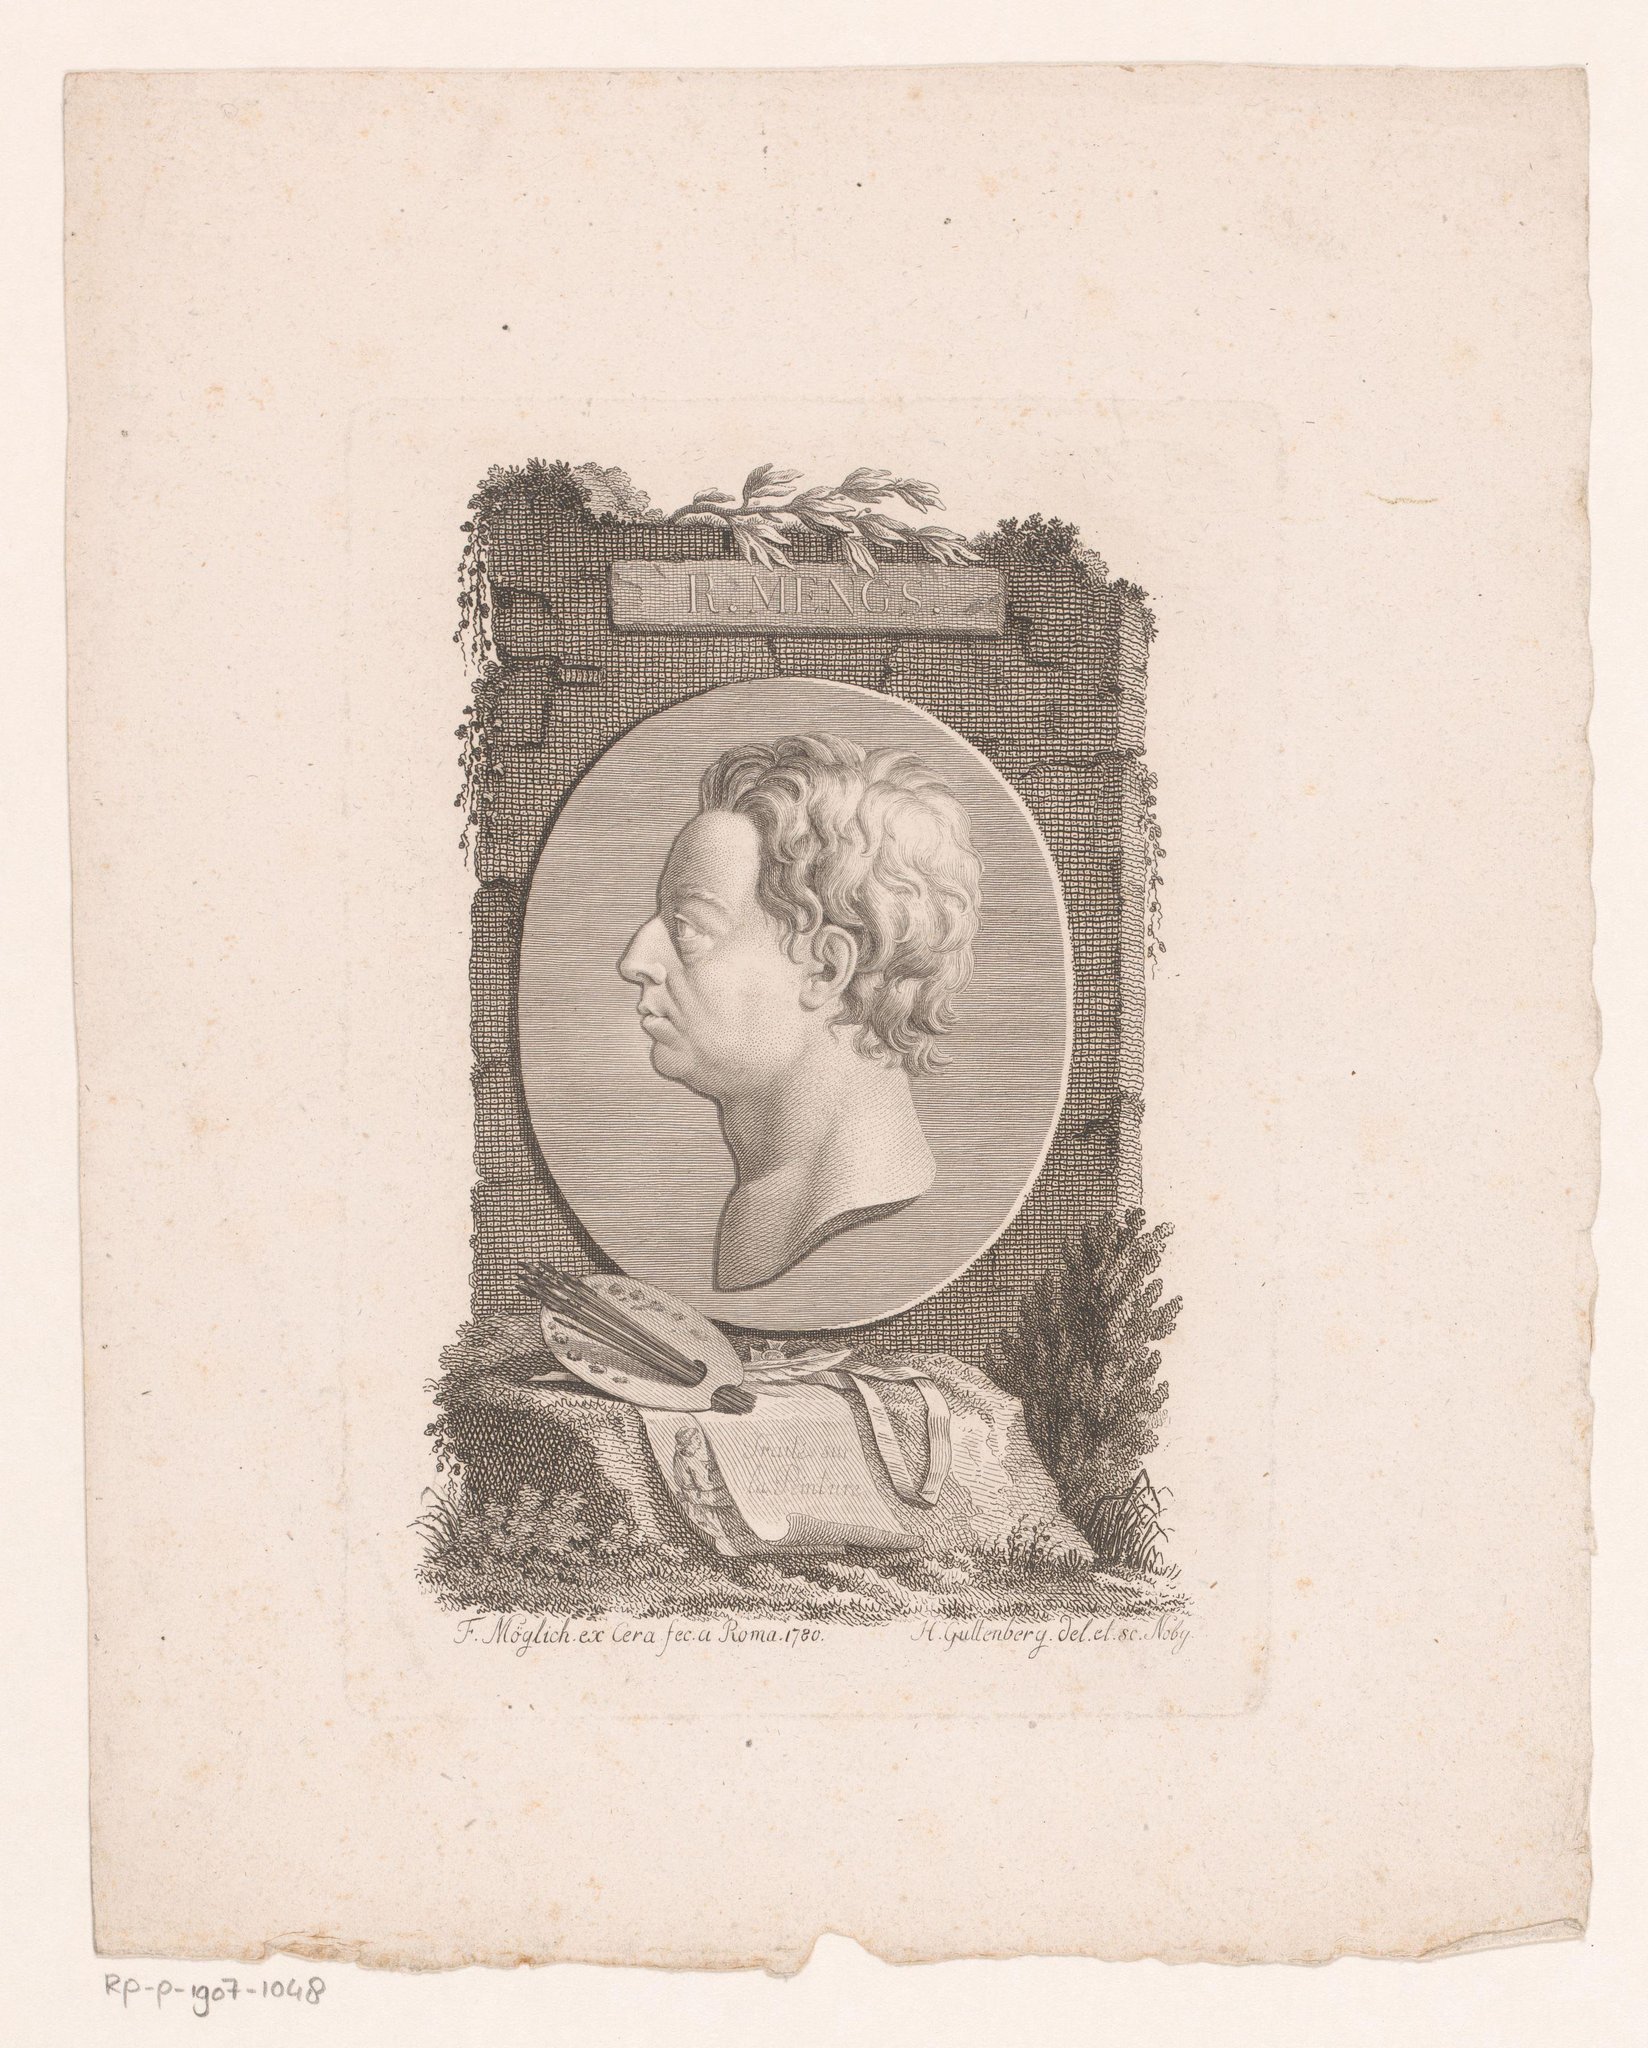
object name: print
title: Portret van Anton Raphael Mengs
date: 1780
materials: paper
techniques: etching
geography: nuremberg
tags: rome, painter, draughtsman, anton raphael mengs, historical persons, tools, implements of painter, medals and other marks of military honour, decorating 'en relief', appliquéing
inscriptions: collector's mark: Lugt 2228